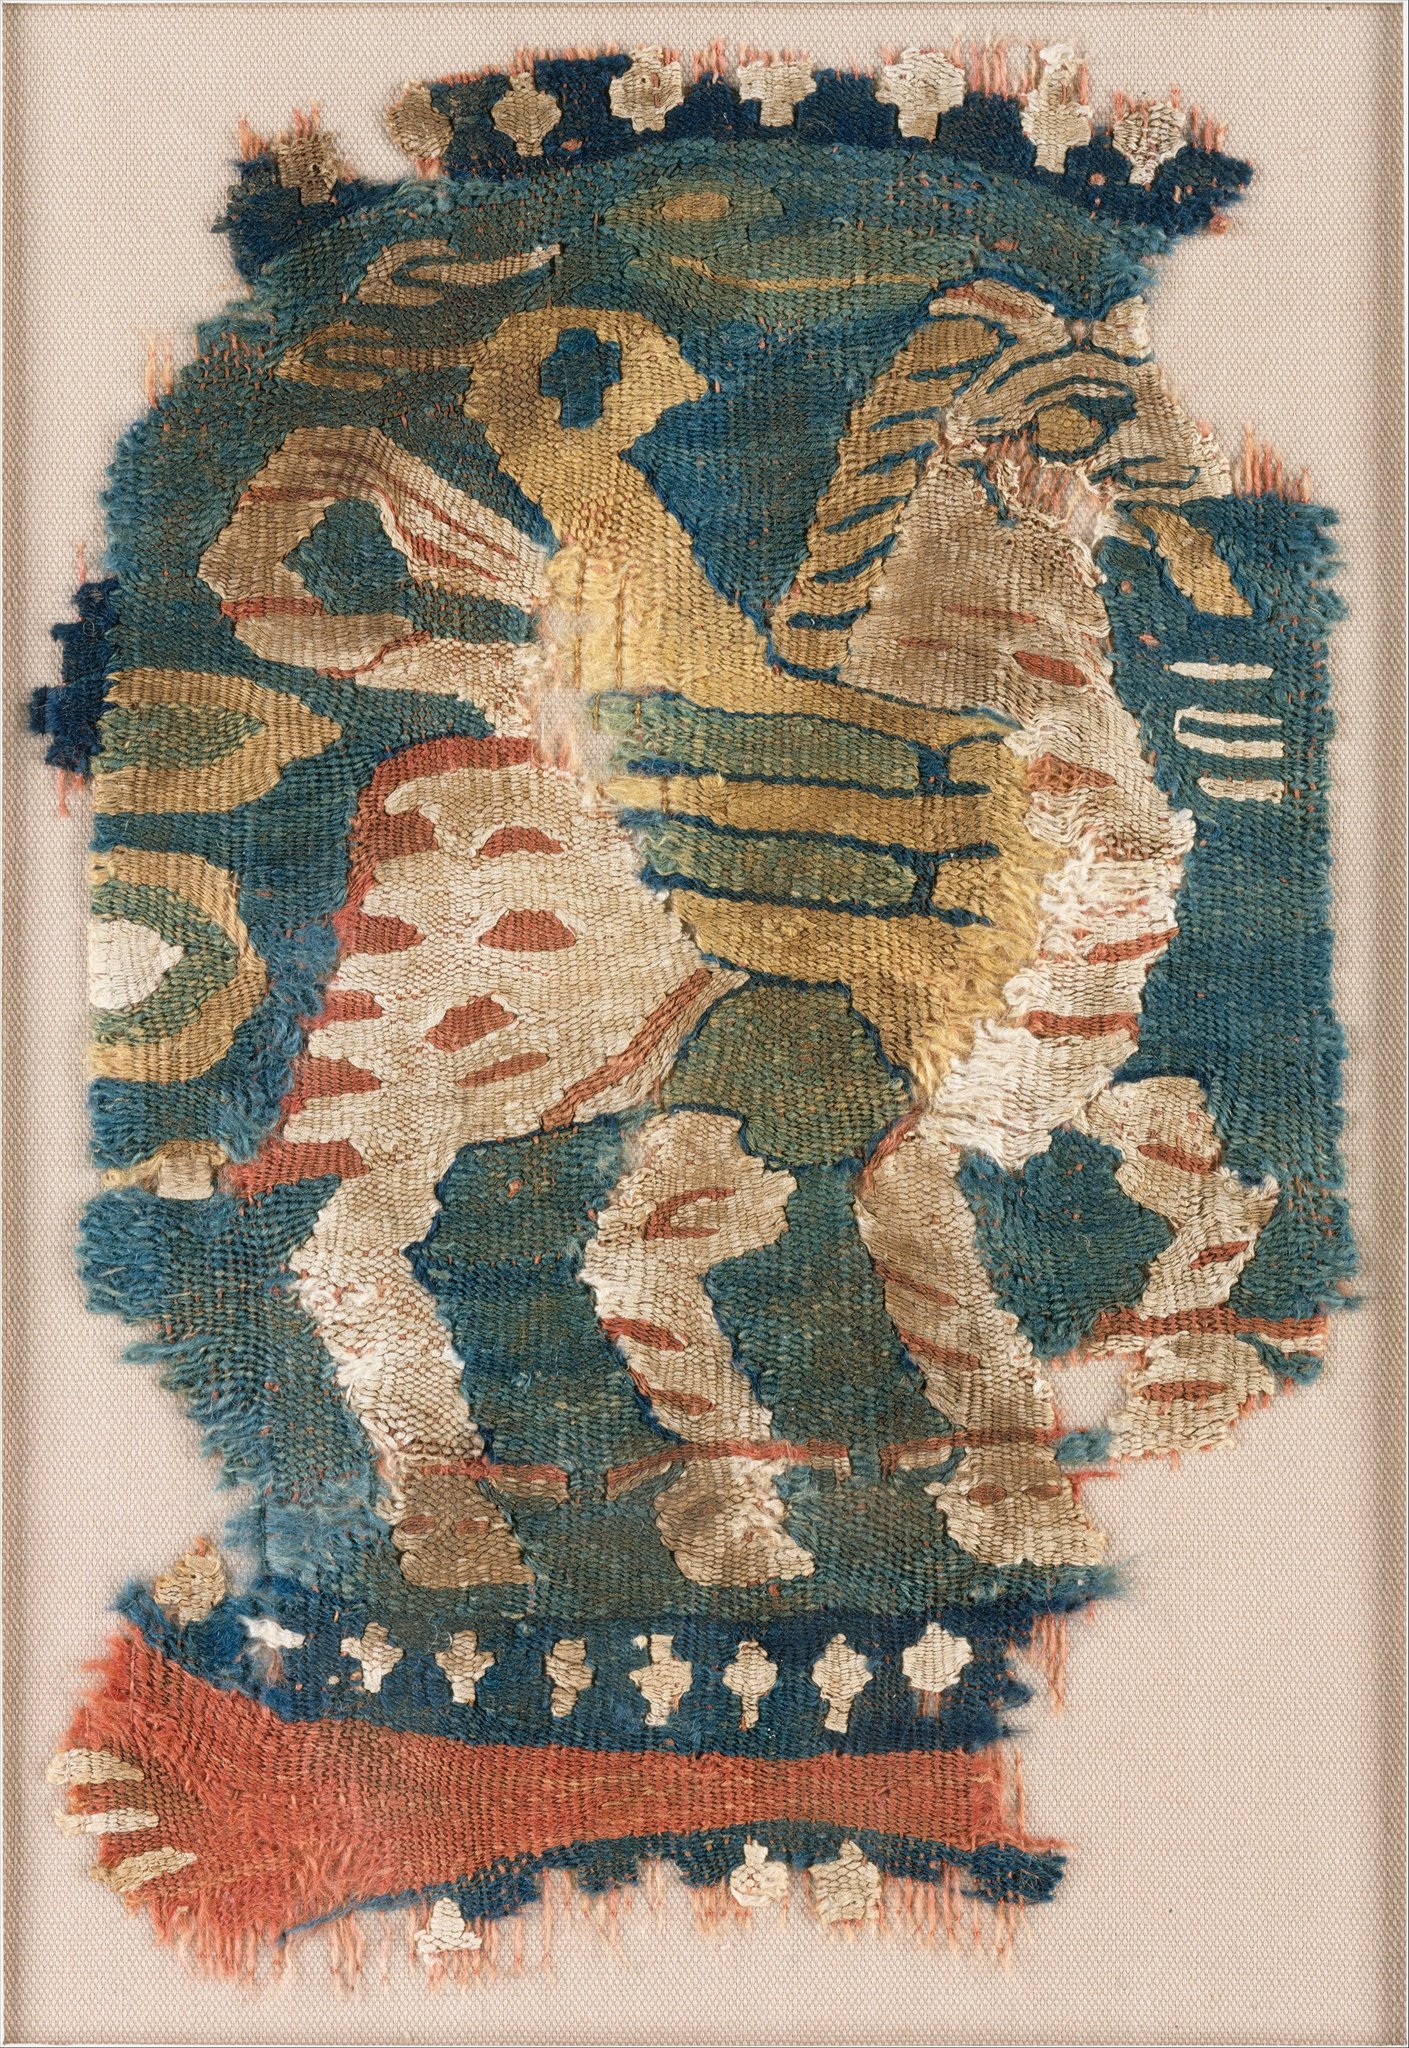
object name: textile fragment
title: Roundel with Winged Horse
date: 801-900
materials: linen, wool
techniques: weave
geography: egypt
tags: mythical creatures